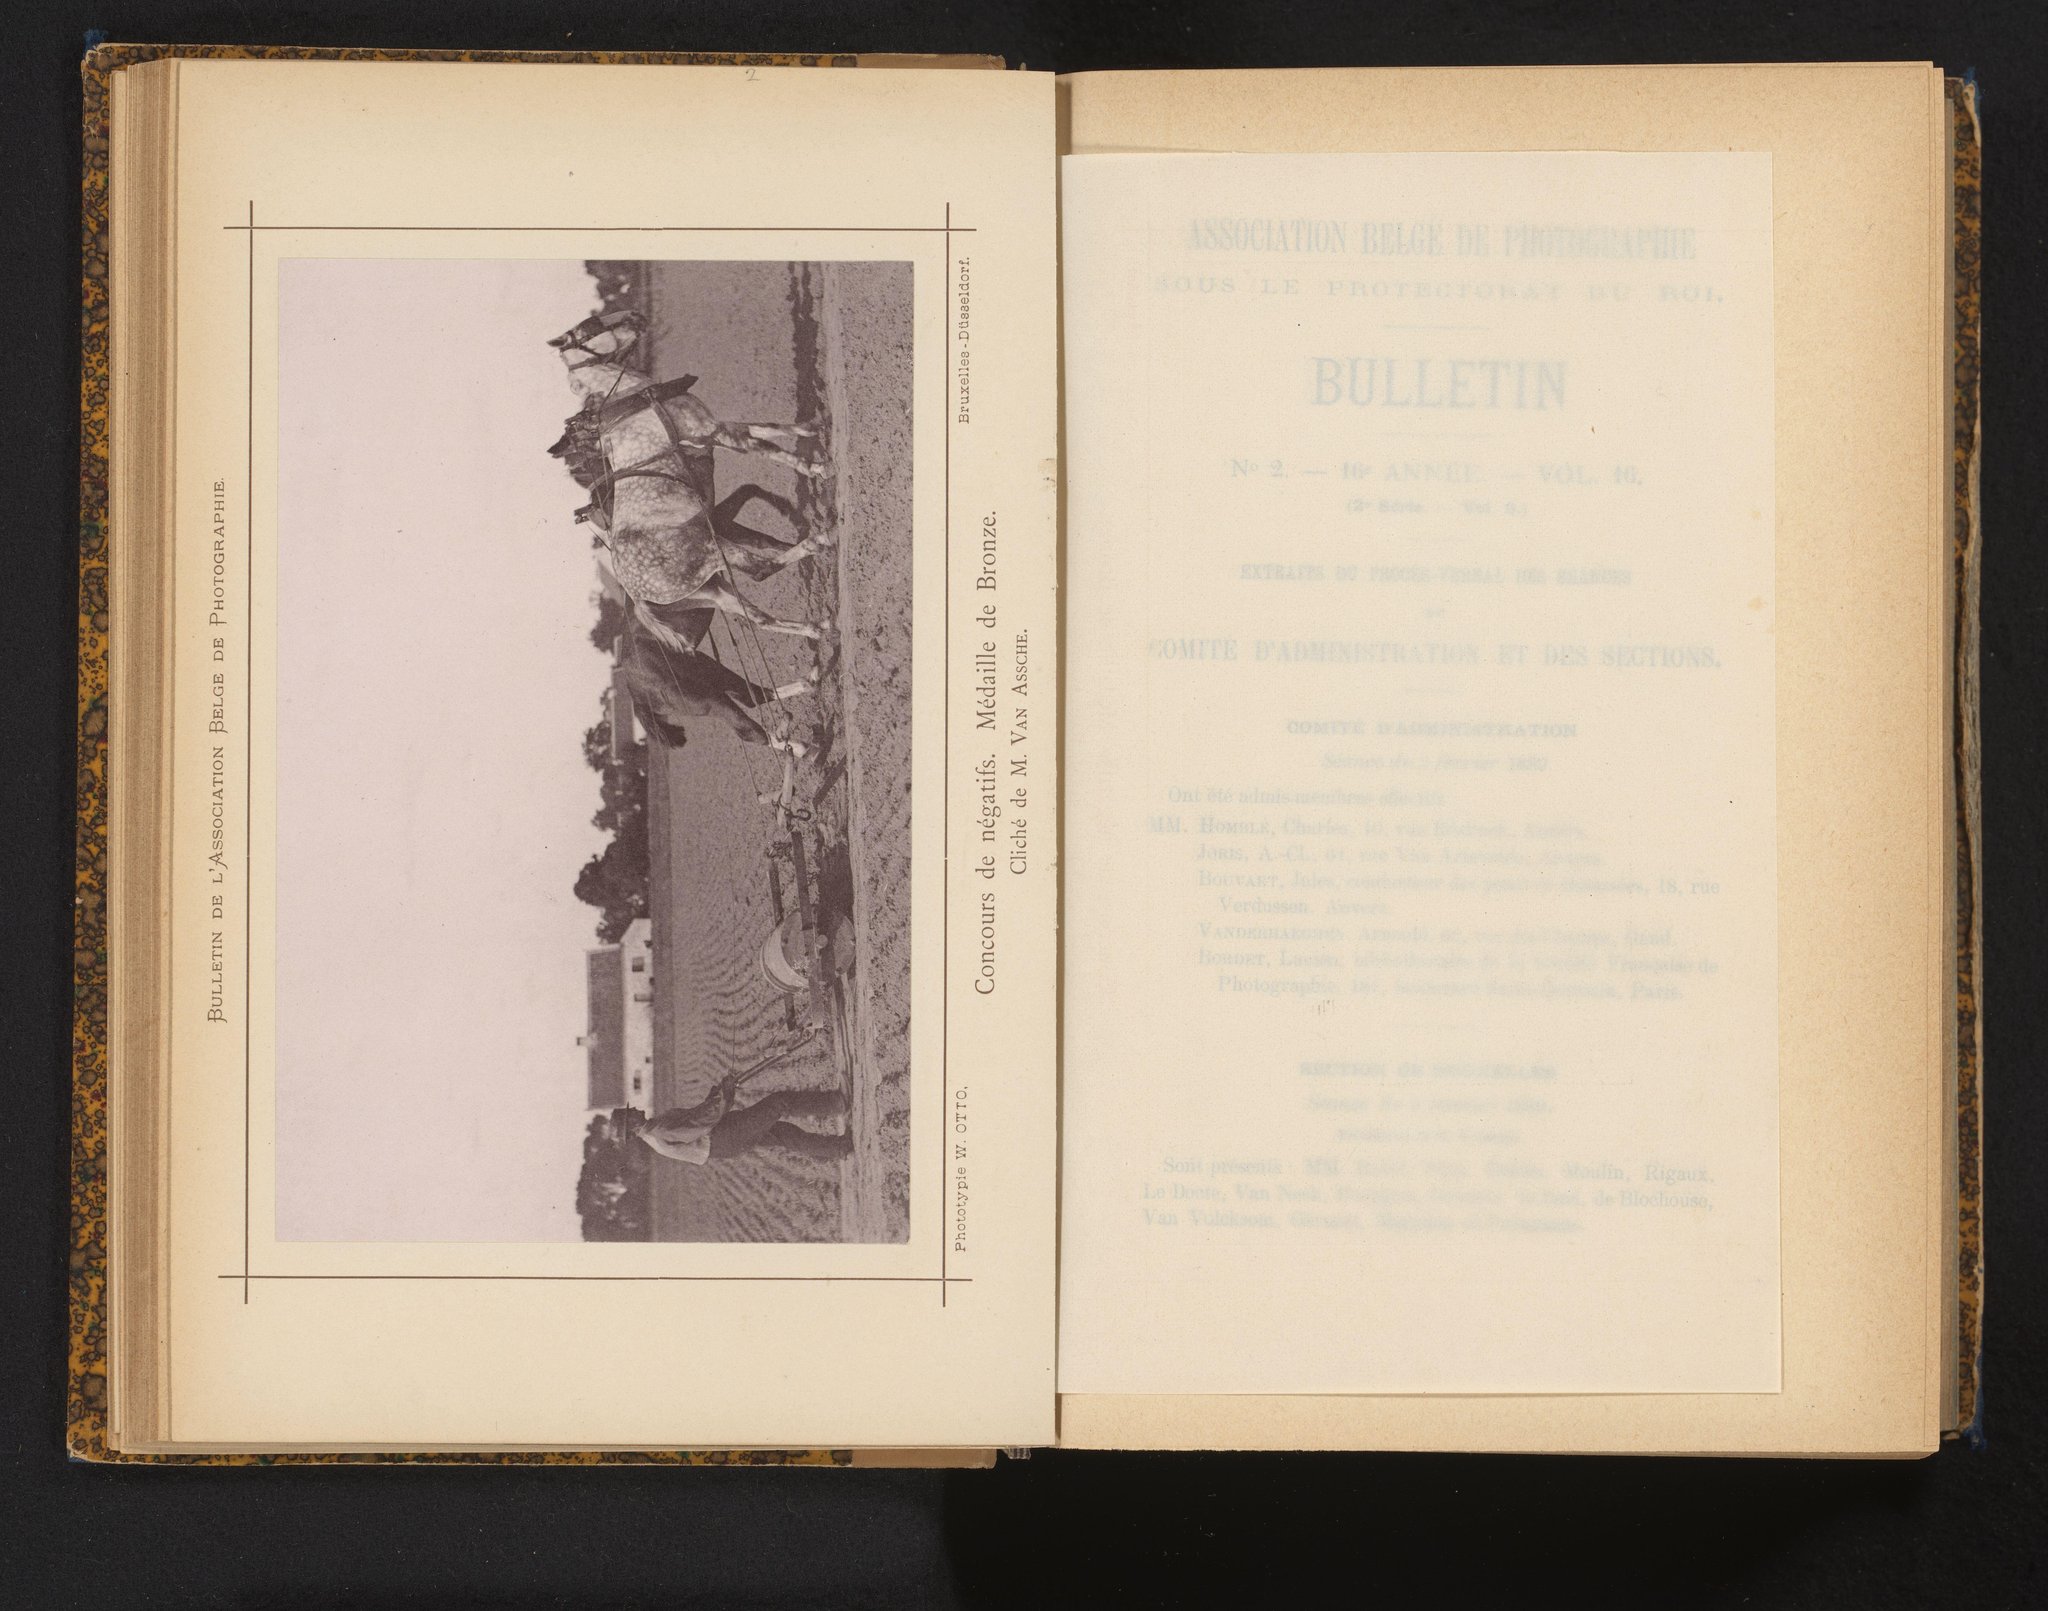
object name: photomechanical print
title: Le paysan au labour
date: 1883-1888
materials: cardboard, paper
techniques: photograph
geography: brussels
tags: rolling ~ soil cultivation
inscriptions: inscription: ‘Concours de négatifs. Médaille de Bronze.’